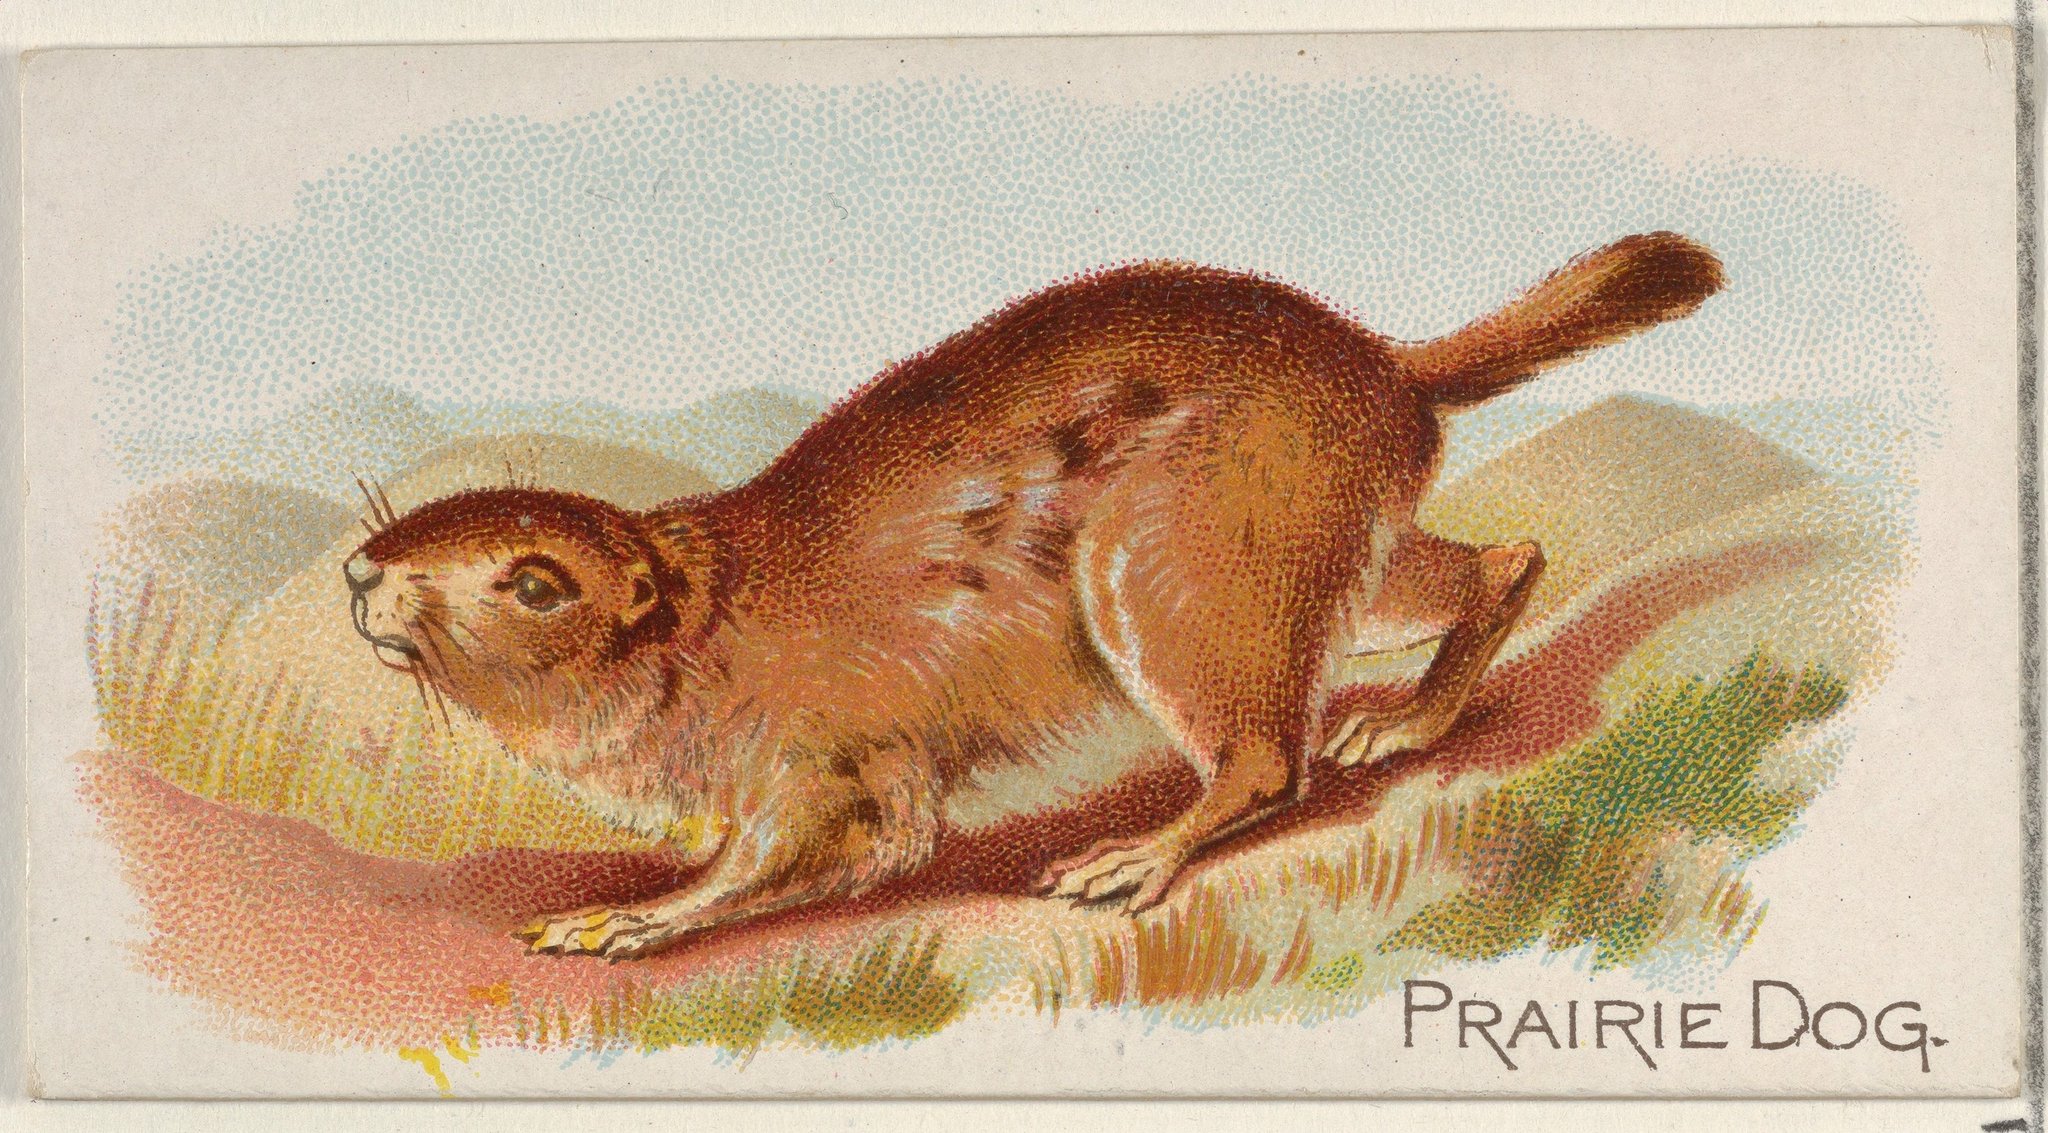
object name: print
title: Prairie Dog, from the Quadrupeds series (N21) for Allen & Ginter Cigarettes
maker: allen & ginter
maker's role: publisher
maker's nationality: american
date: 1890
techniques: color lithograph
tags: animals